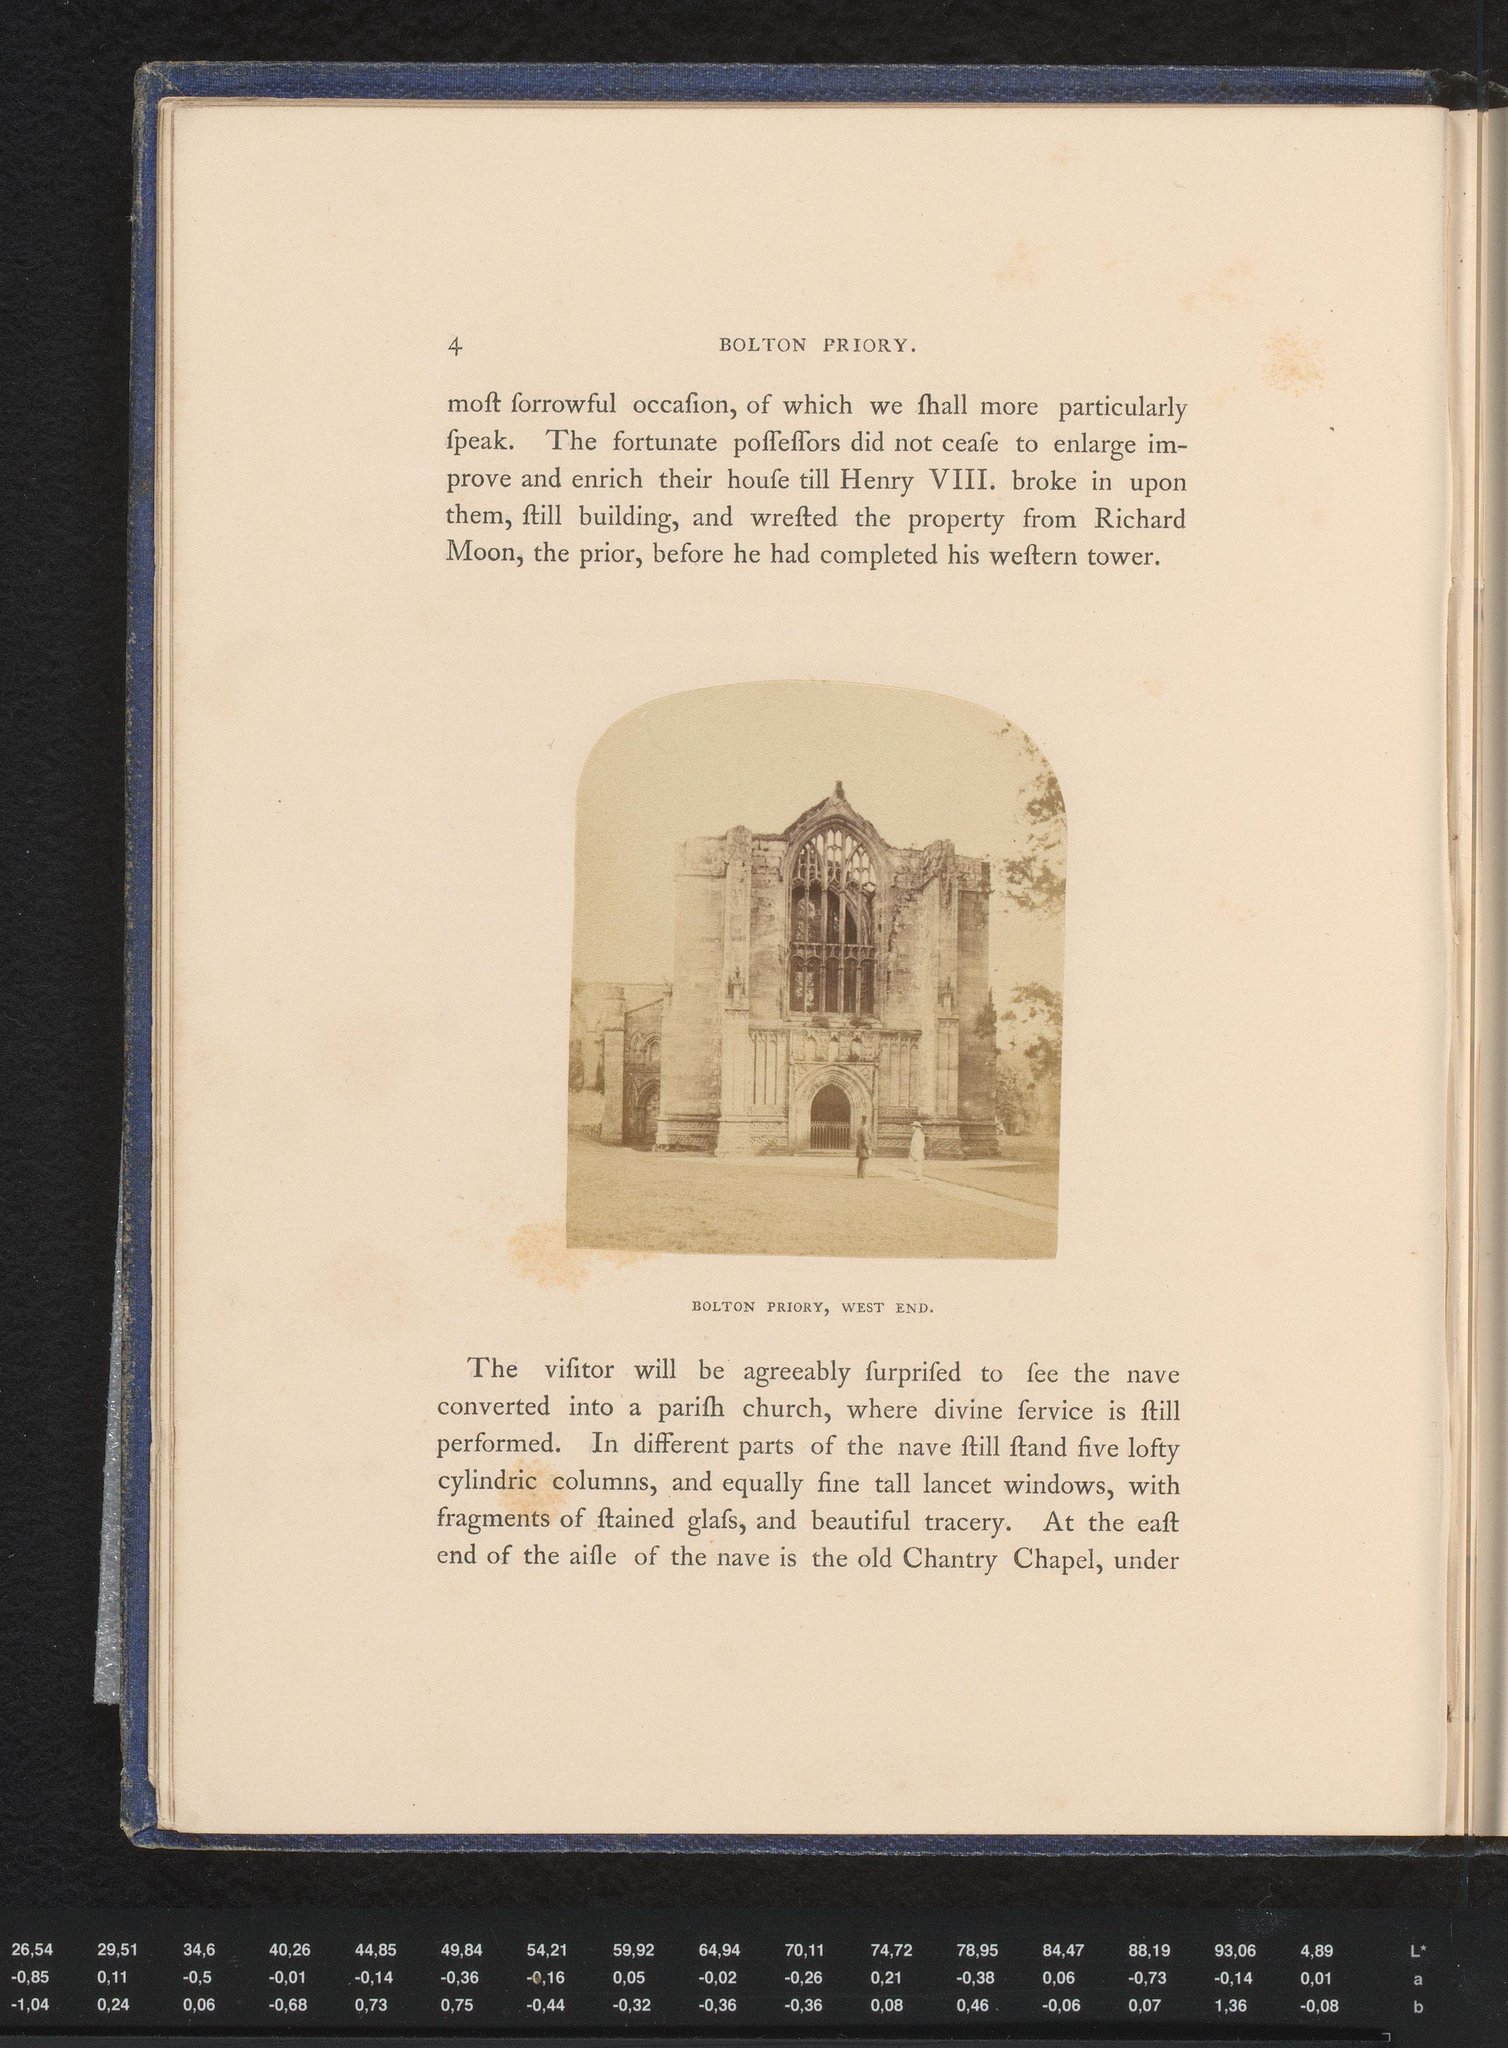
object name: page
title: Bolton Priory, West End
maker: william russell sedgfield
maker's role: fotograaf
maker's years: 1826-1902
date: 1857-1862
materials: paper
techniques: albumen print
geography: bolton abbey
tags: ruin of church, monastery, etc.